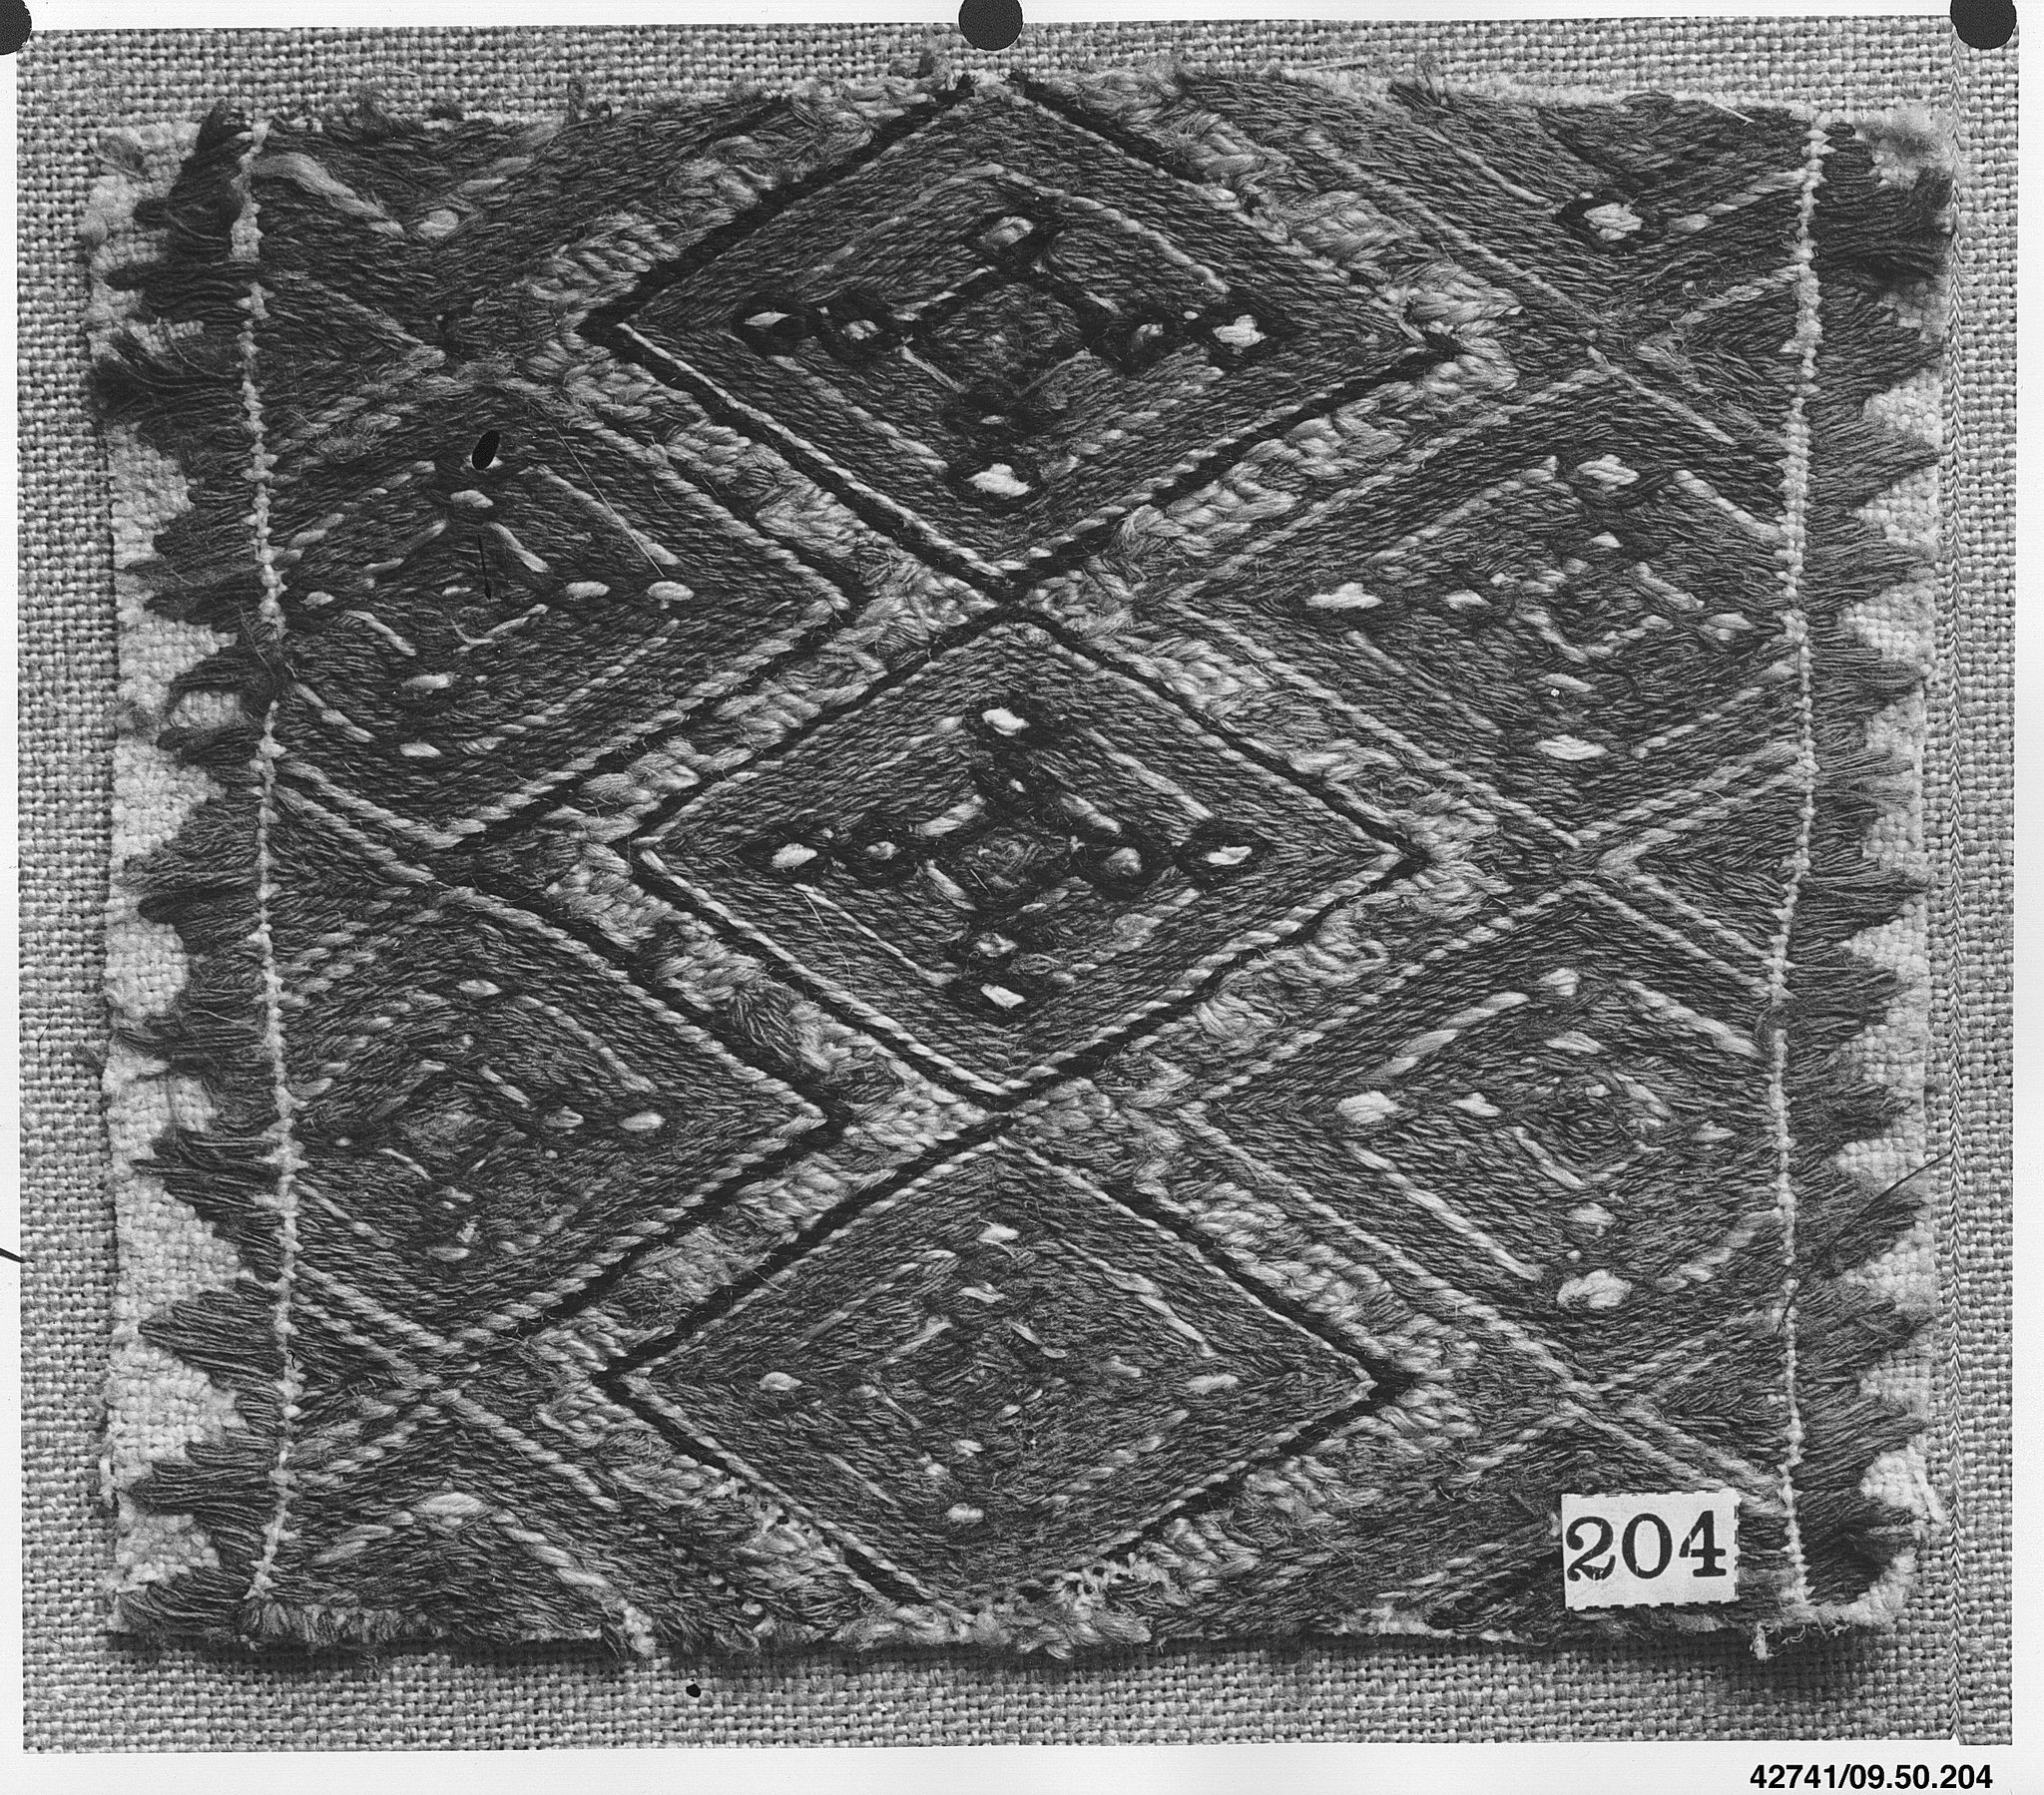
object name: costume fragment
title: Peasant costume fragment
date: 1701-1900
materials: canvas, wool